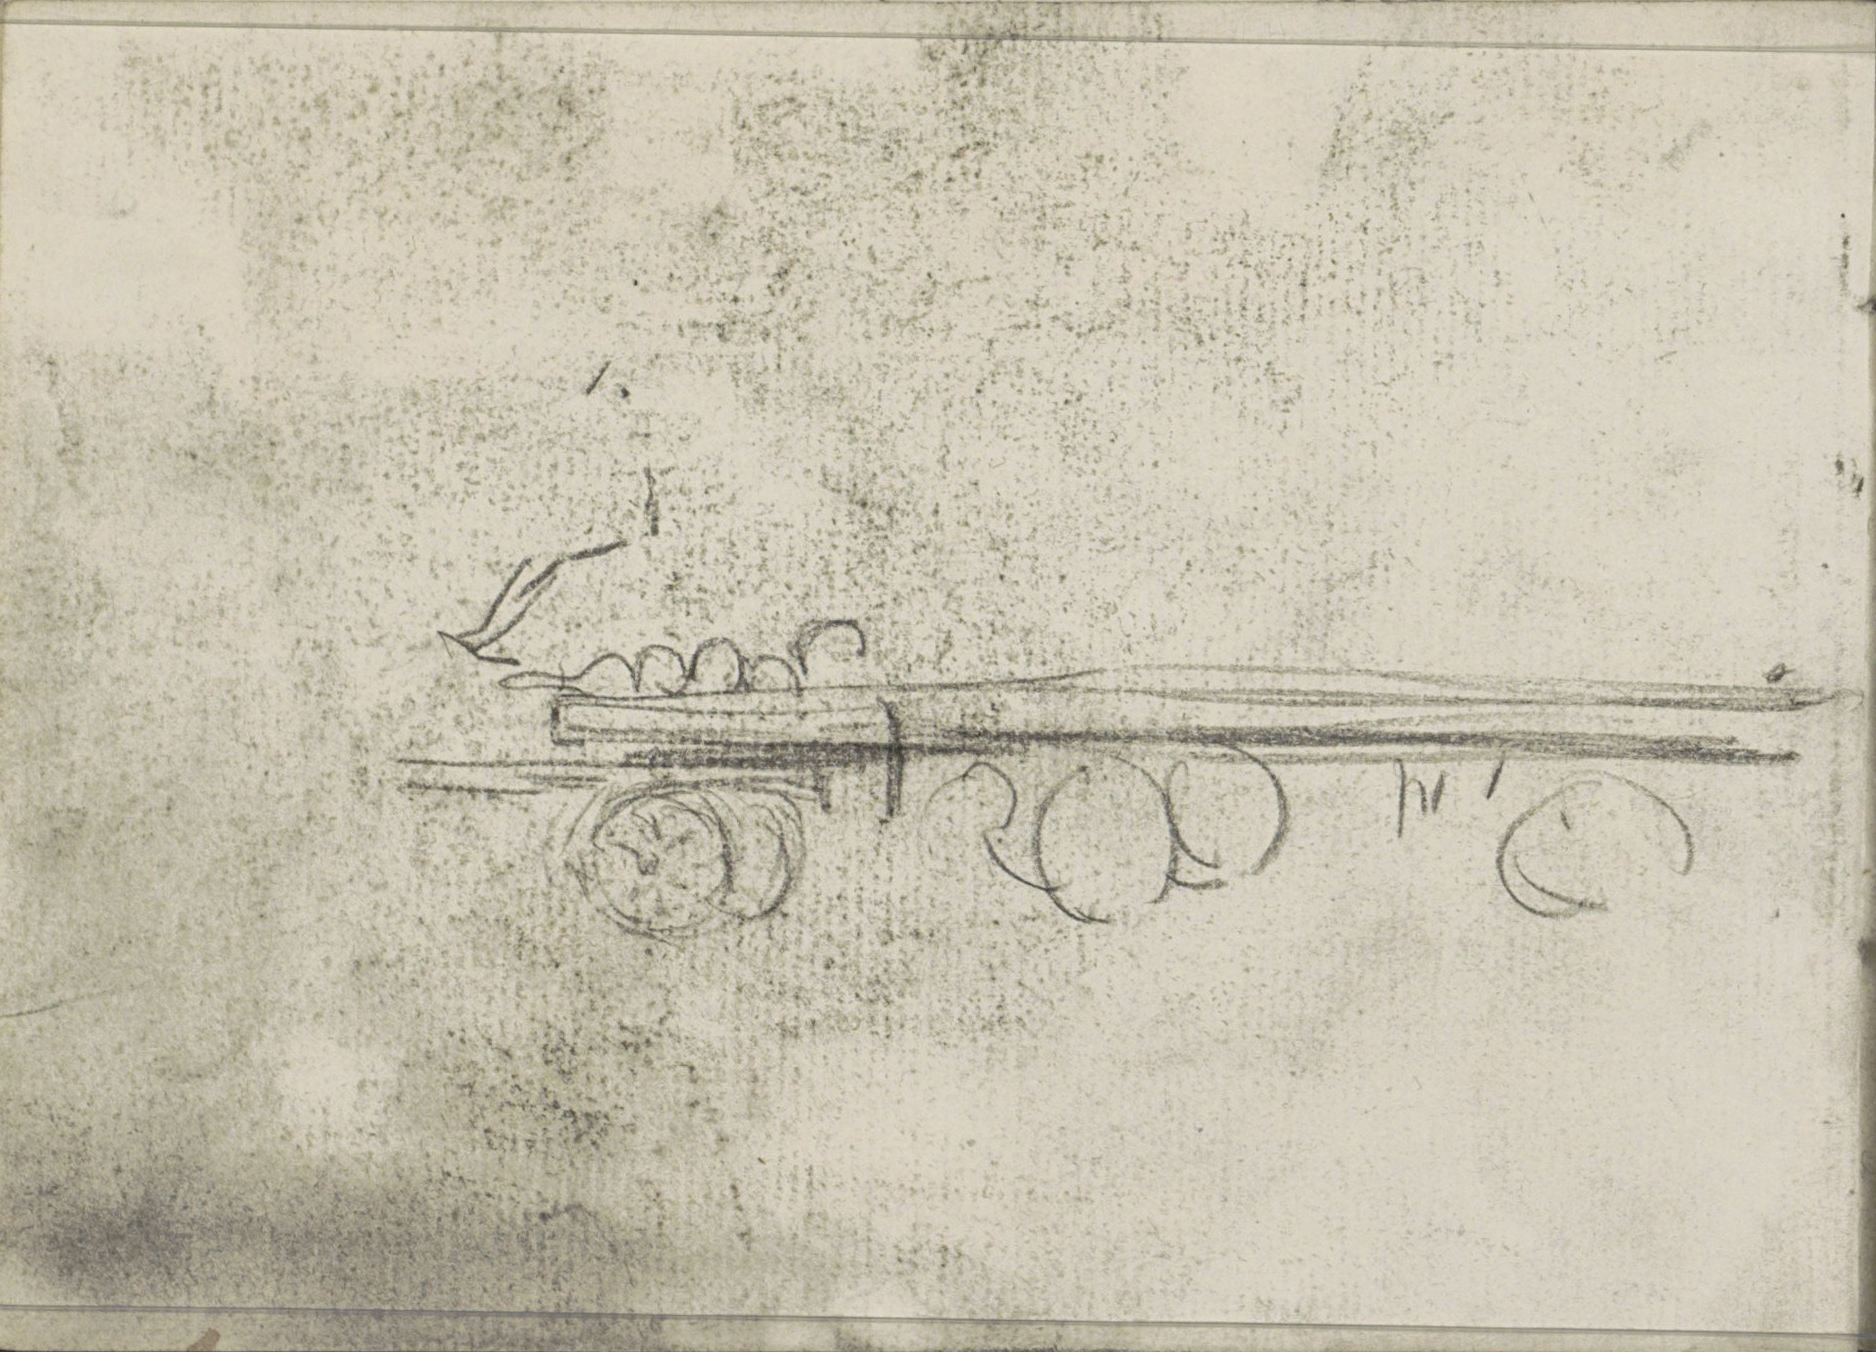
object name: sketchbook leaf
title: Sleperswagen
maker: isaac israels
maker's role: draughtsman, painter, print maker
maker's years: 1865-1934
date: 1875-1934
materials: chalk, paper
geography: amsterdam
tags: (farm) wagon, freight wagon, cart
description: Blad 5 verso uit schetsboek XXXI met 10 bladen.